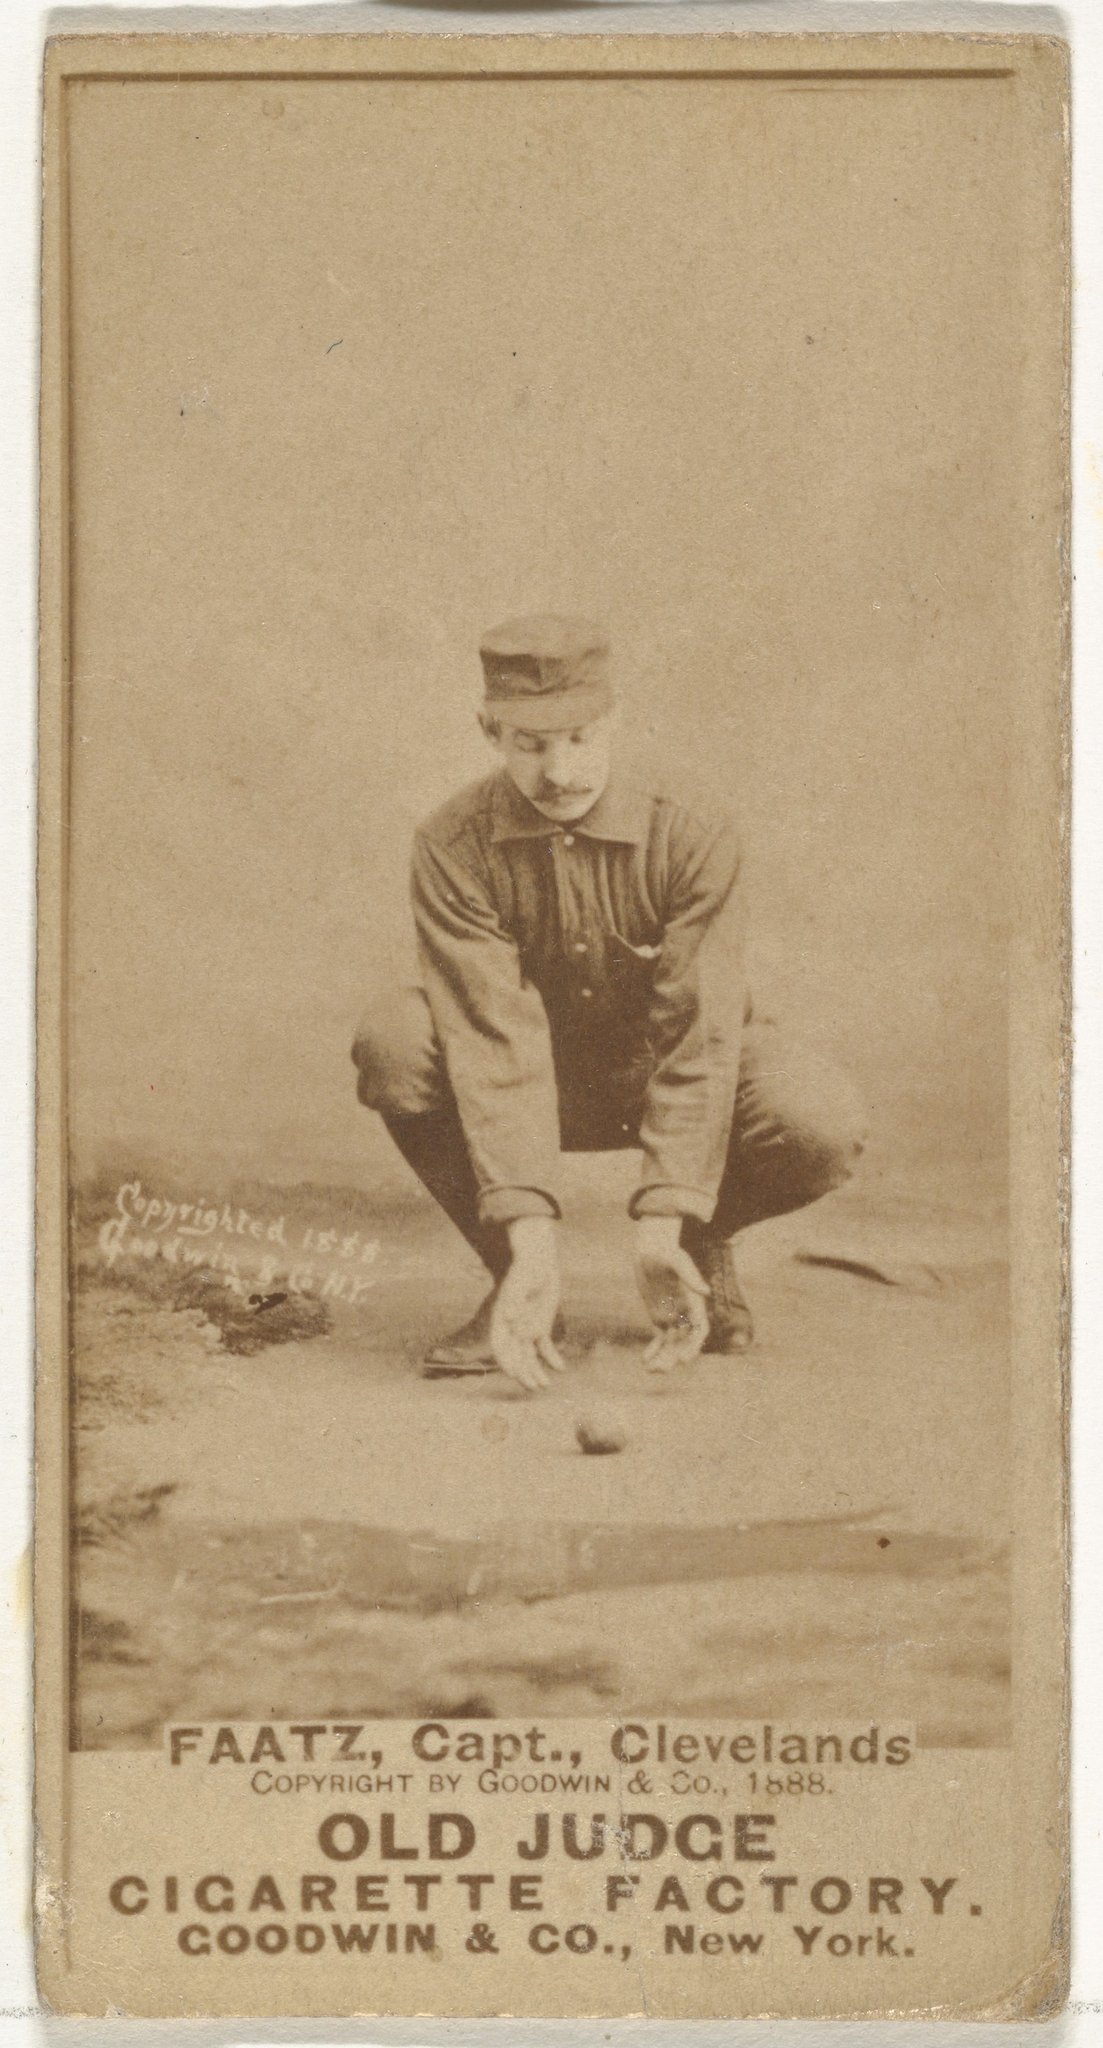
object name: baseball card, photograph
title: Jayson S. "Jay" Faatz, Captain, Cleveland, from the Old Judge series (N172) for Old Judge Cigarettes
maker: goodwin & company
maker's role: publisher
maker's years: 1850-1950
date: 1888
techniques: albumen silver print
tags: men,portraits,baseball,athletes